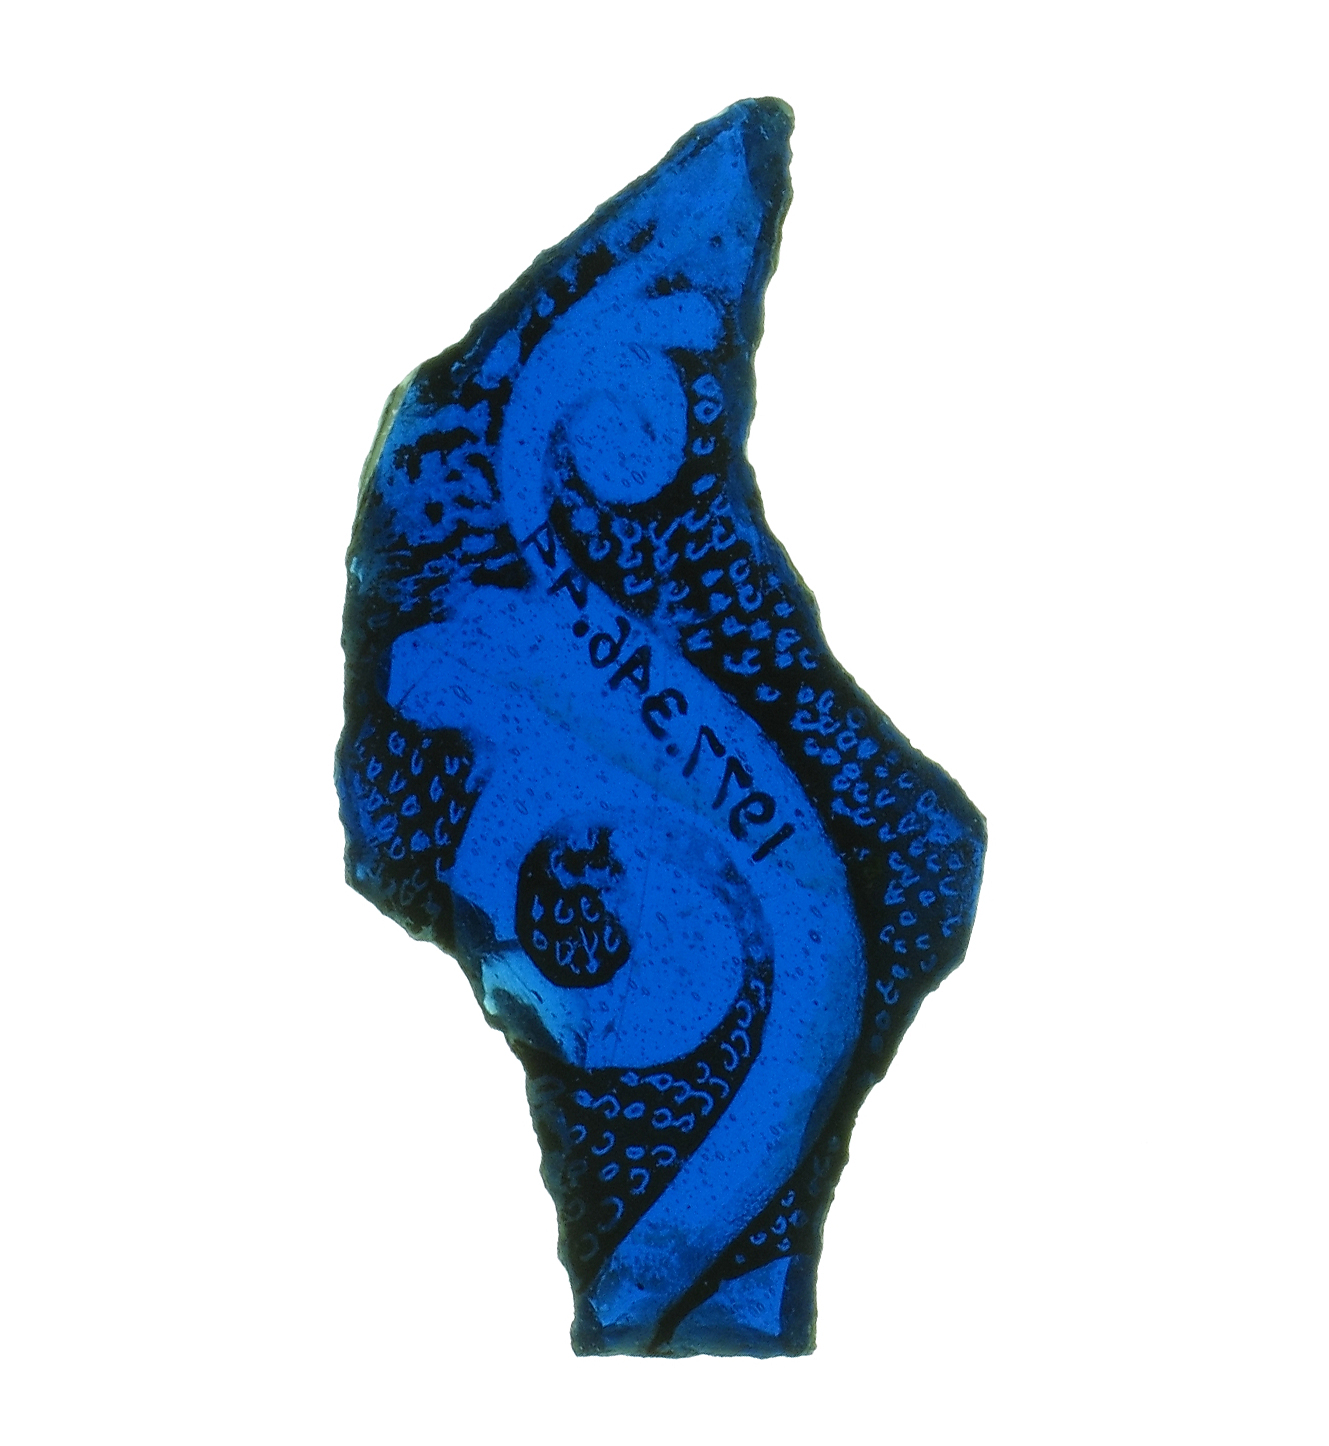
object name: fragment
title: Glass Fragment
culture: french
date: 1101-1400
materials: glass, metal, paint